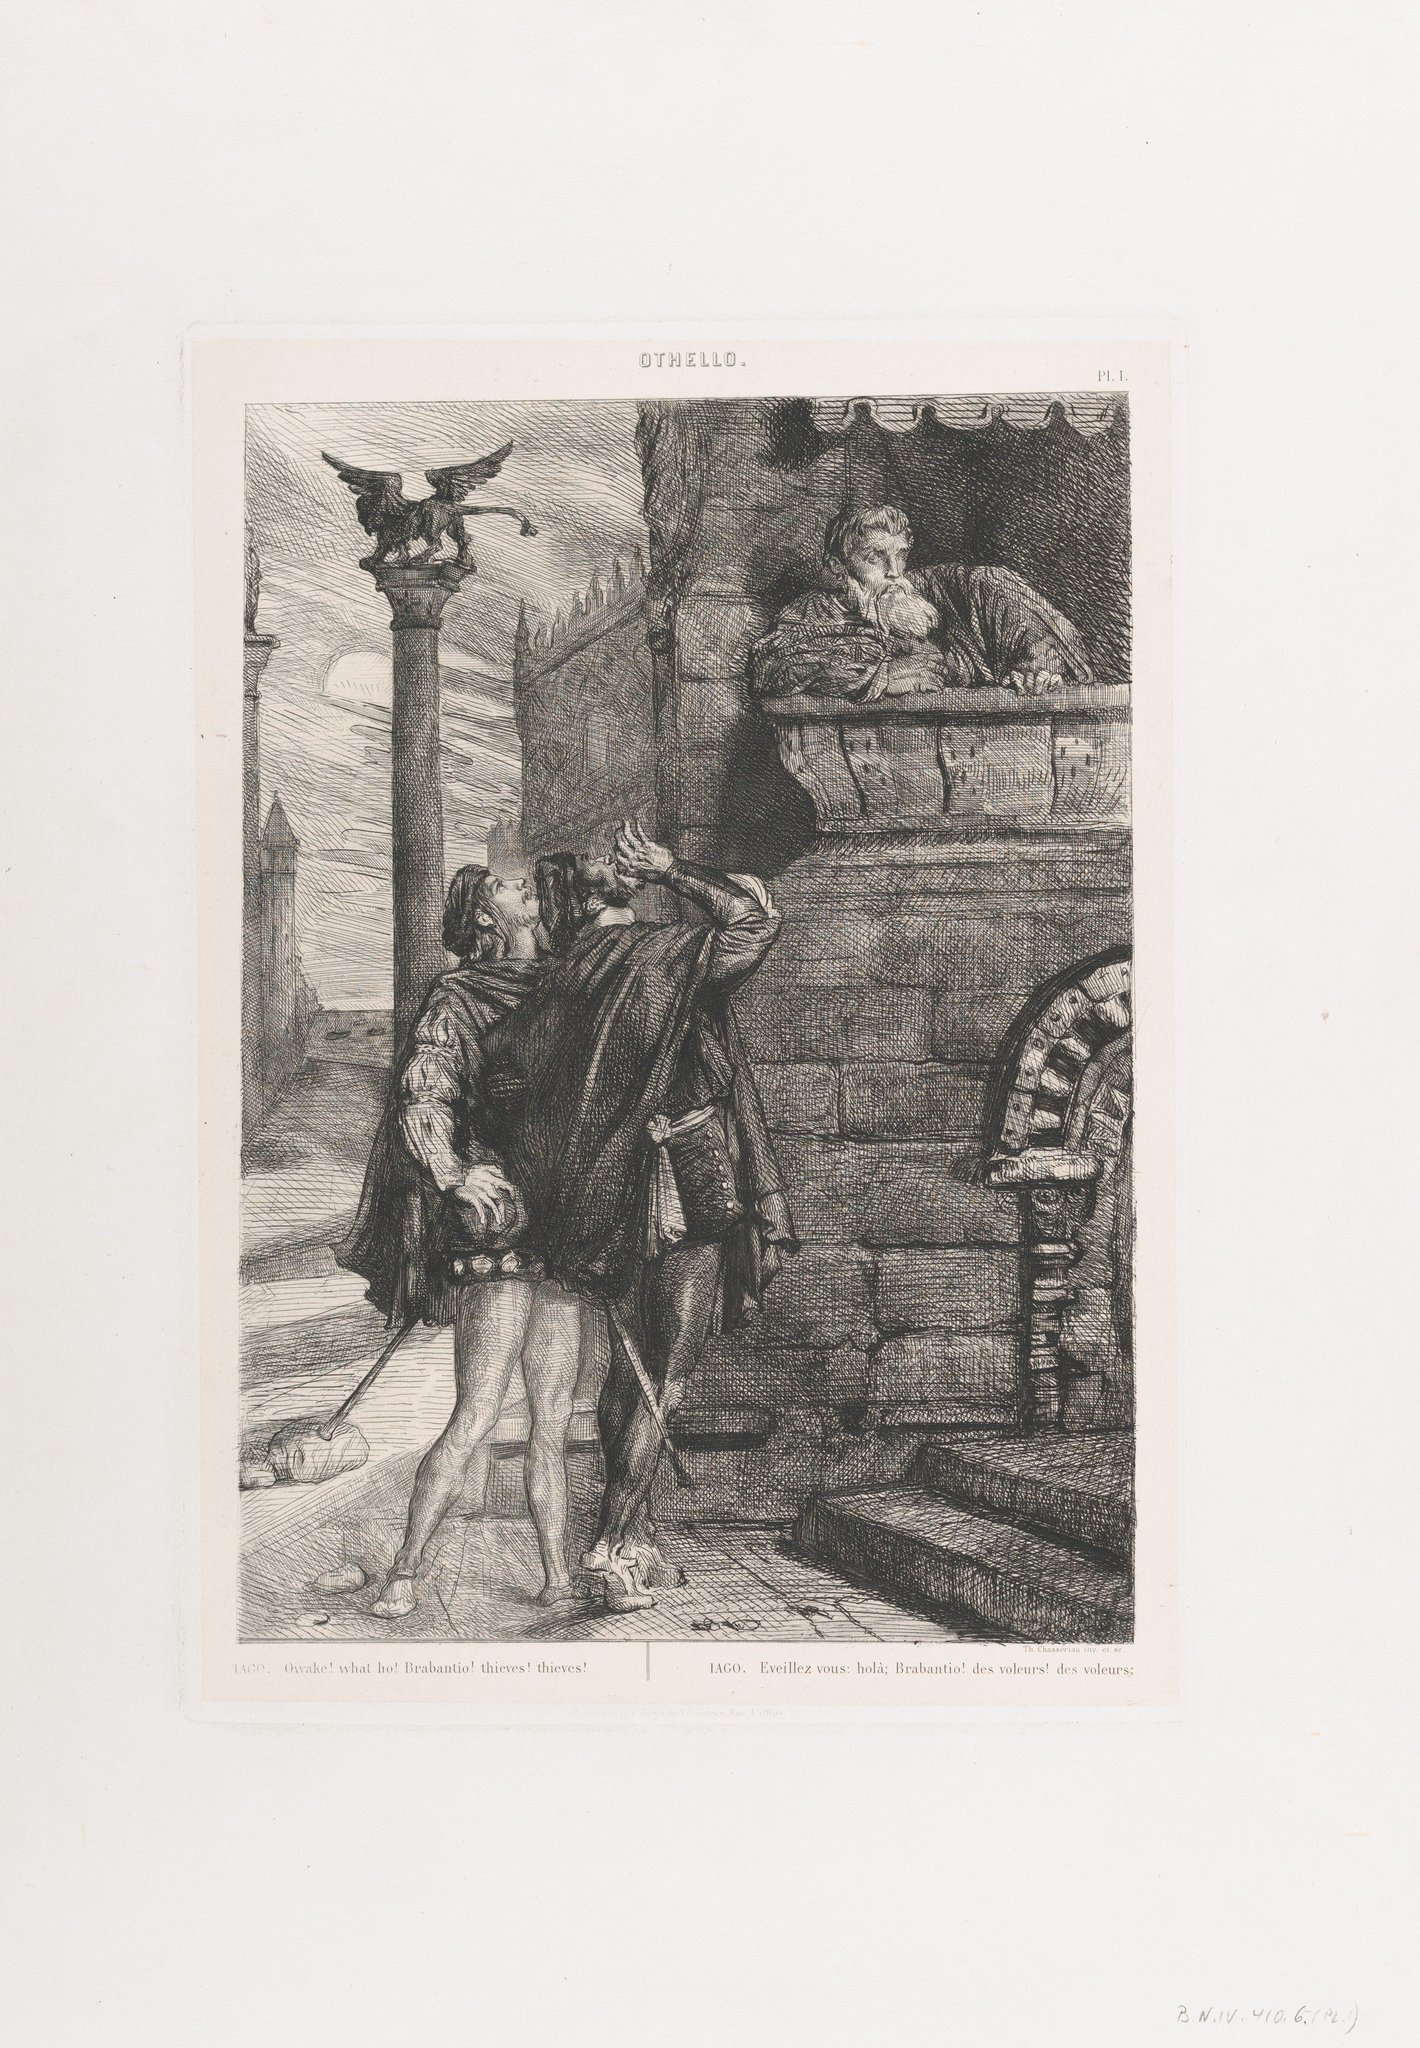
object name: print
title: "Owake! what ho! Brabantio! thieves! thieves!": plate 1 from Othello (Act 1, Scene 1)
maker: théodore chassériau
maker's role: artist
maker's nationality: french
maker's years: 1819-1856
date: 1844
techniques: printmaking, engraving, etching, roulette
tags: shakespeare,men